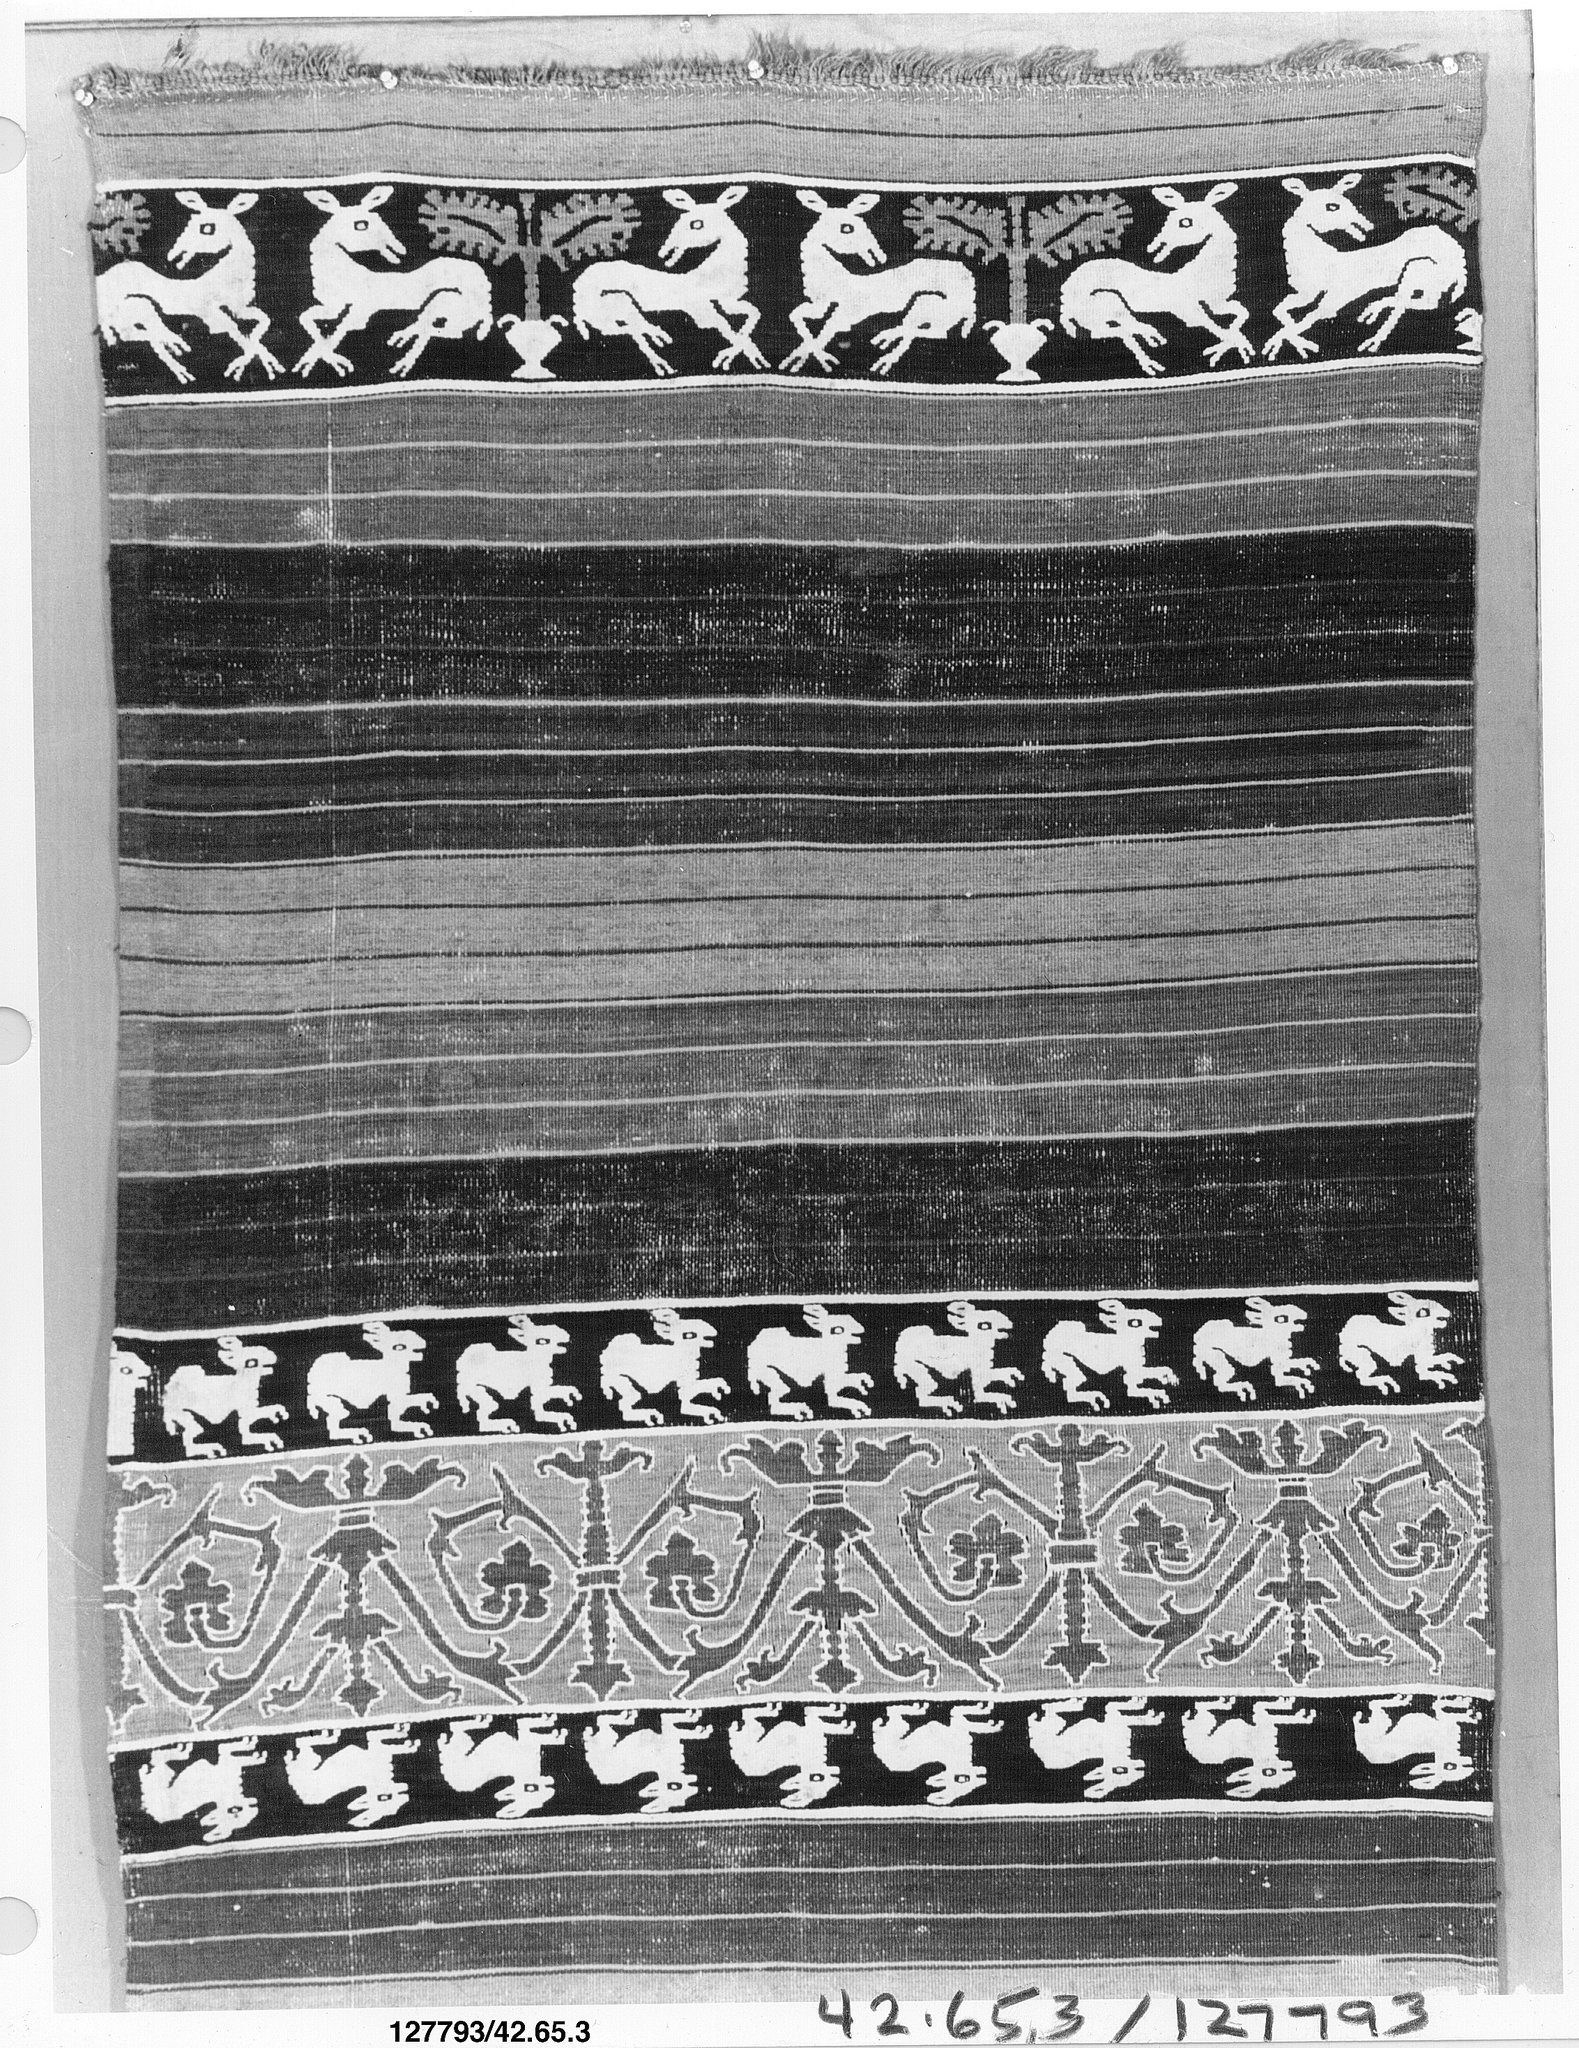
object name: panel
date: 1601-1800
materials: linen, wool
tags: deer,rabbits